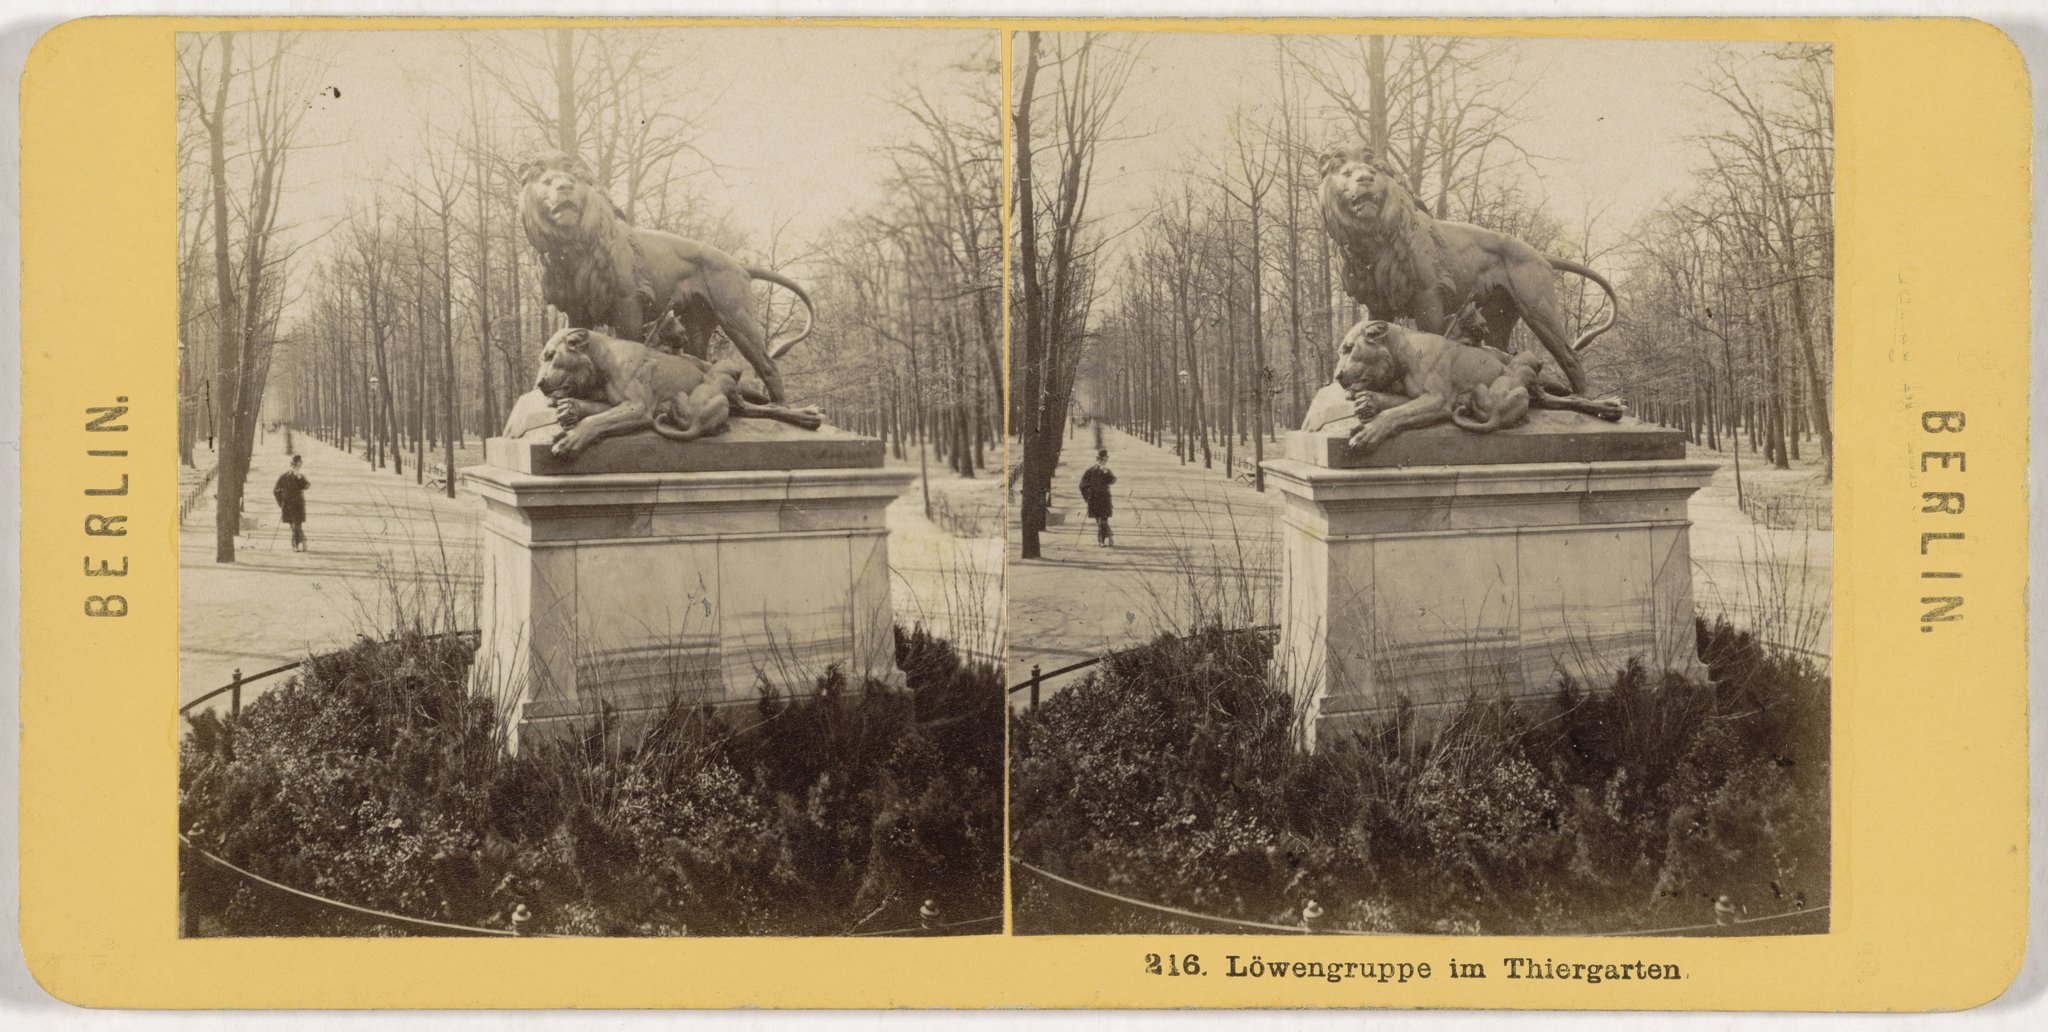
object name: stereograph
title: Standbeeld met een groep leeuwen in Tiergarten, Berlijn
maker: Anonymous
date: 1873-1890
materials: cardboard, paper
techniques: albumen print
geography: berlin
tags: monument, statue, public gardens, park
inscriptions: number: ‘216.’, inscription: ‘30f’